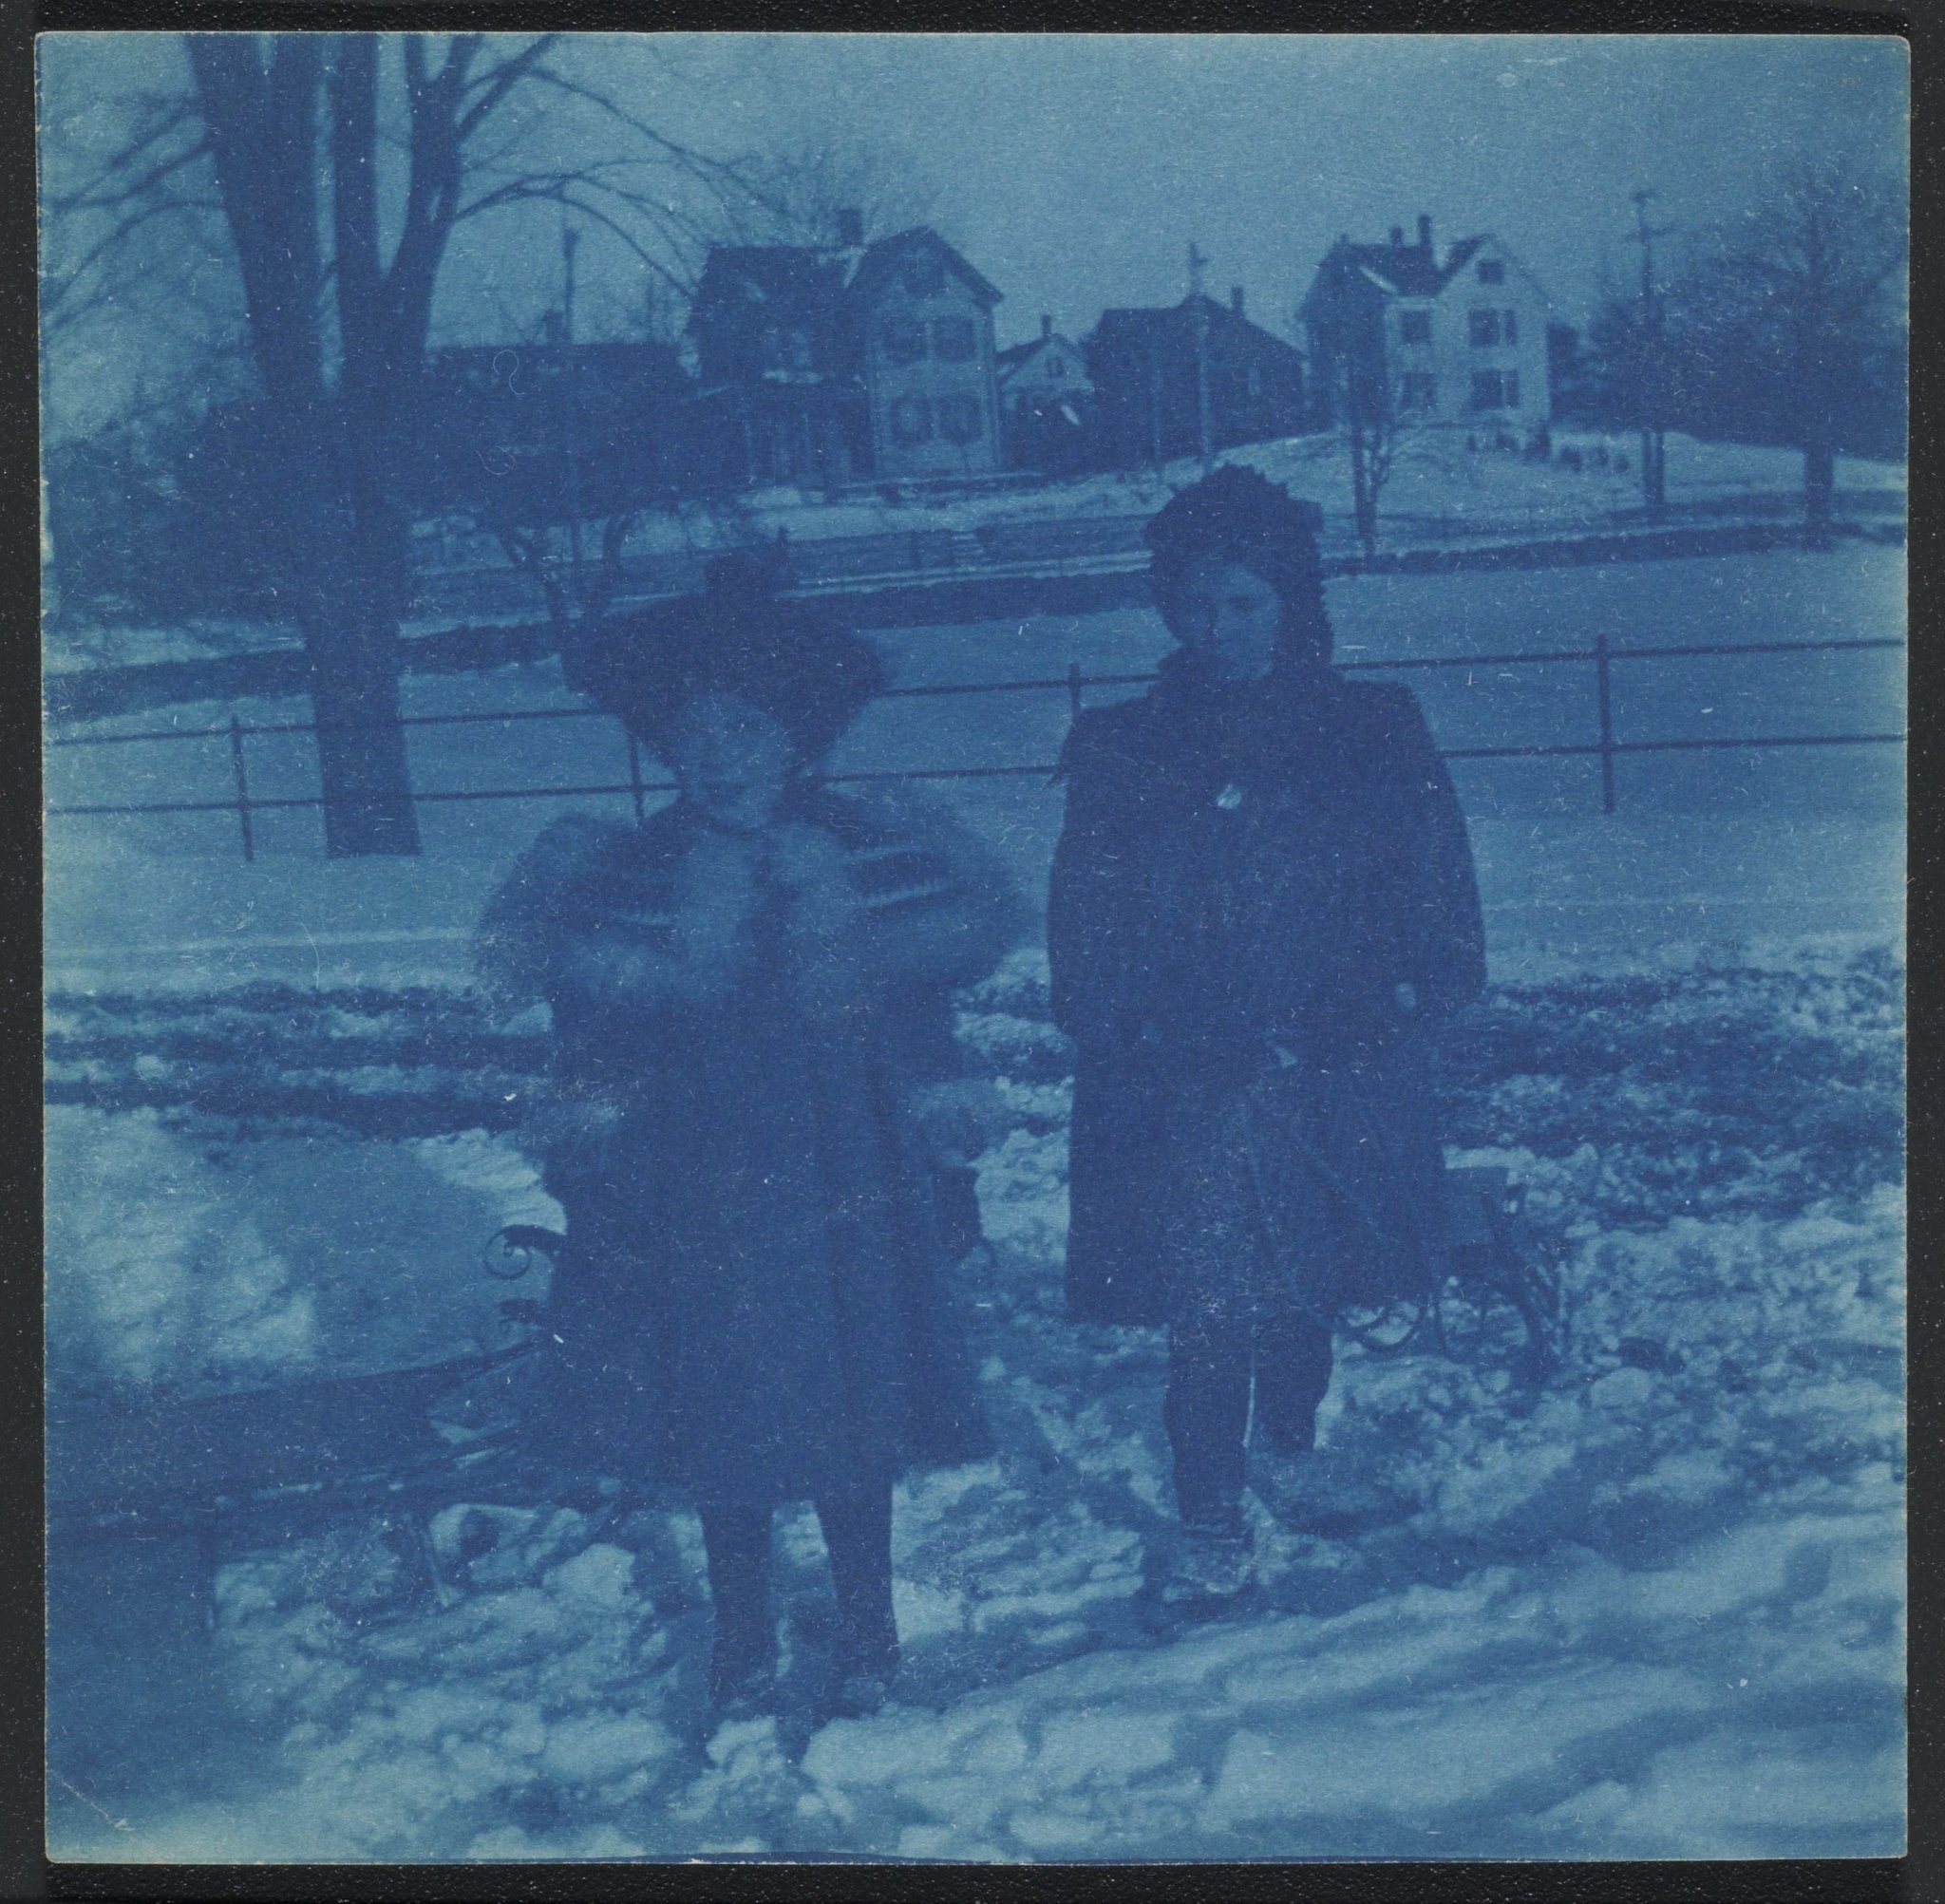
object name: photograph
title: Twee kinderen in de sneeuw, Verenigde Staten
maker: Anonymous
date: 1900-1920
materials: paper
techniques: cyanotype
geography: united states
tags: child, historical persons, snow, united states of america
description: Onderdeel van Fotoalbum met 53 cyanotypieën van kinderen, paarden, huizen, boten en strandtaferelen in de Verenigde Staten.